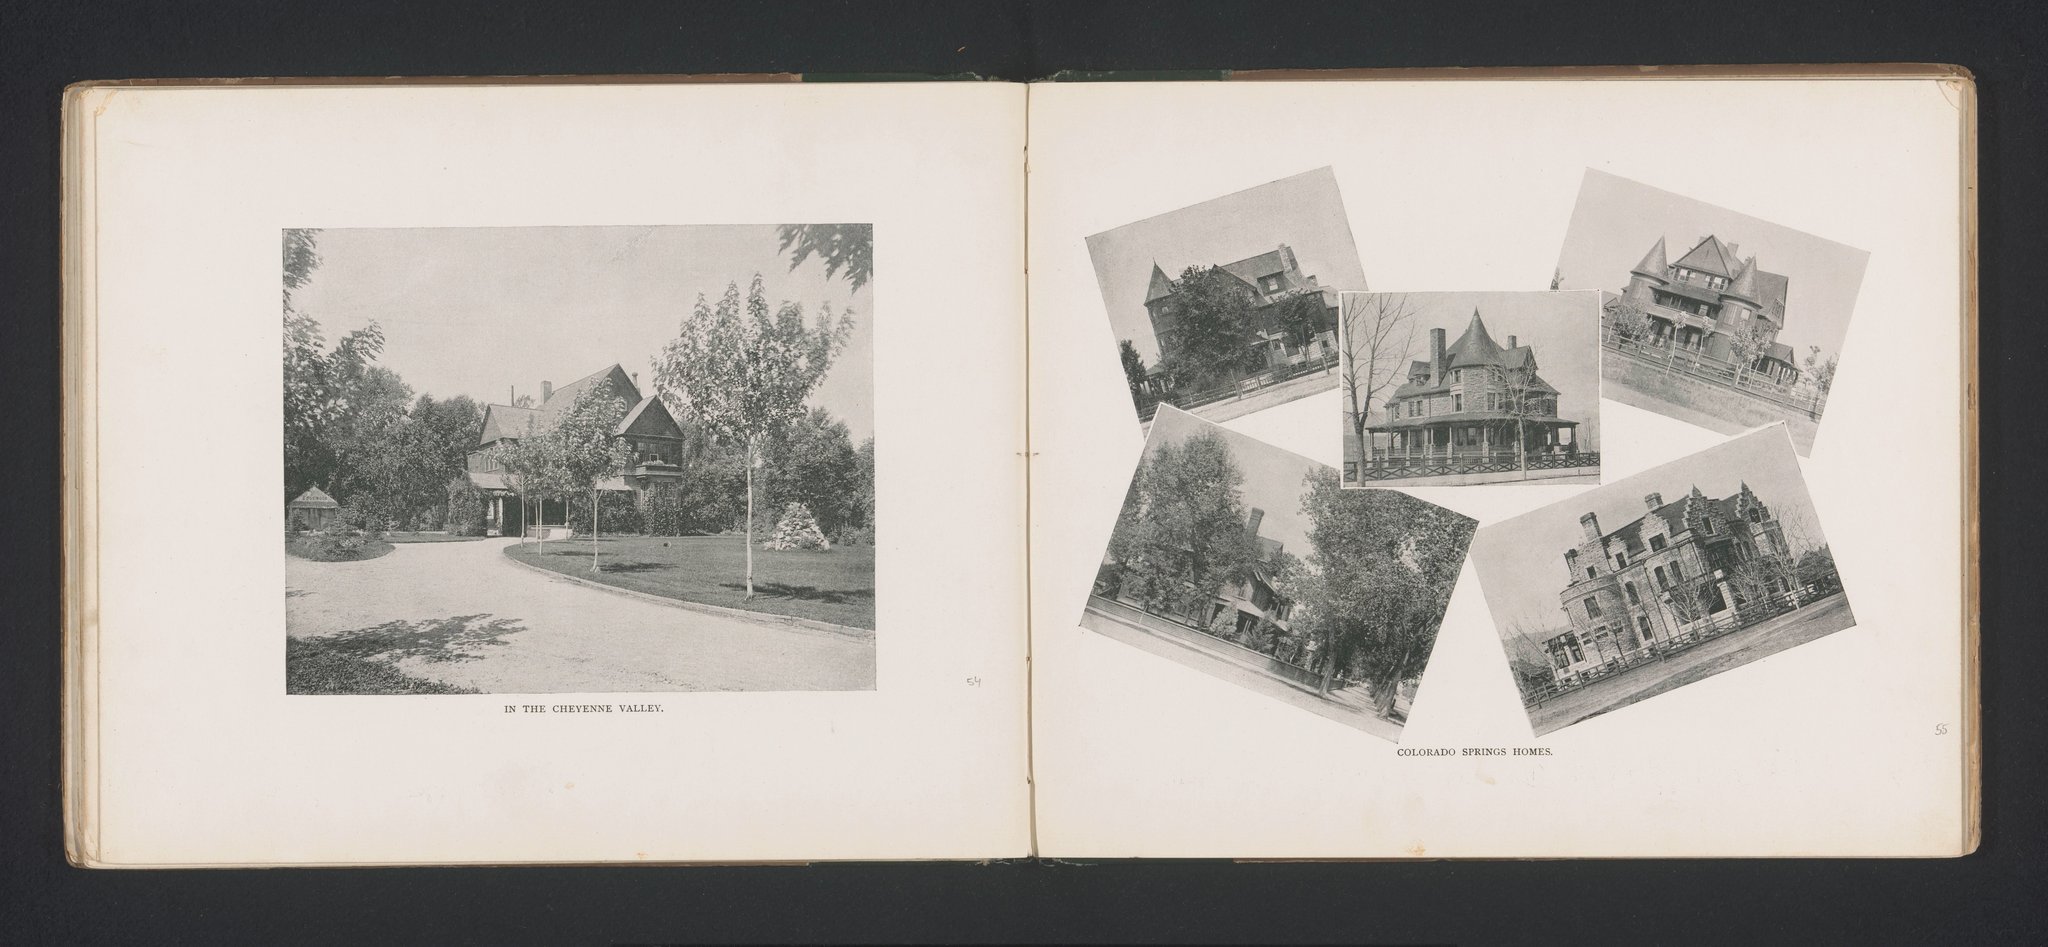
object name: photomontage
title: Fotomontage van villa's in Colorado Springs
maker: Anonymous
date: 1888-1893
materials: paper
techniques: autotype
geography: colorado springs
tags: villa